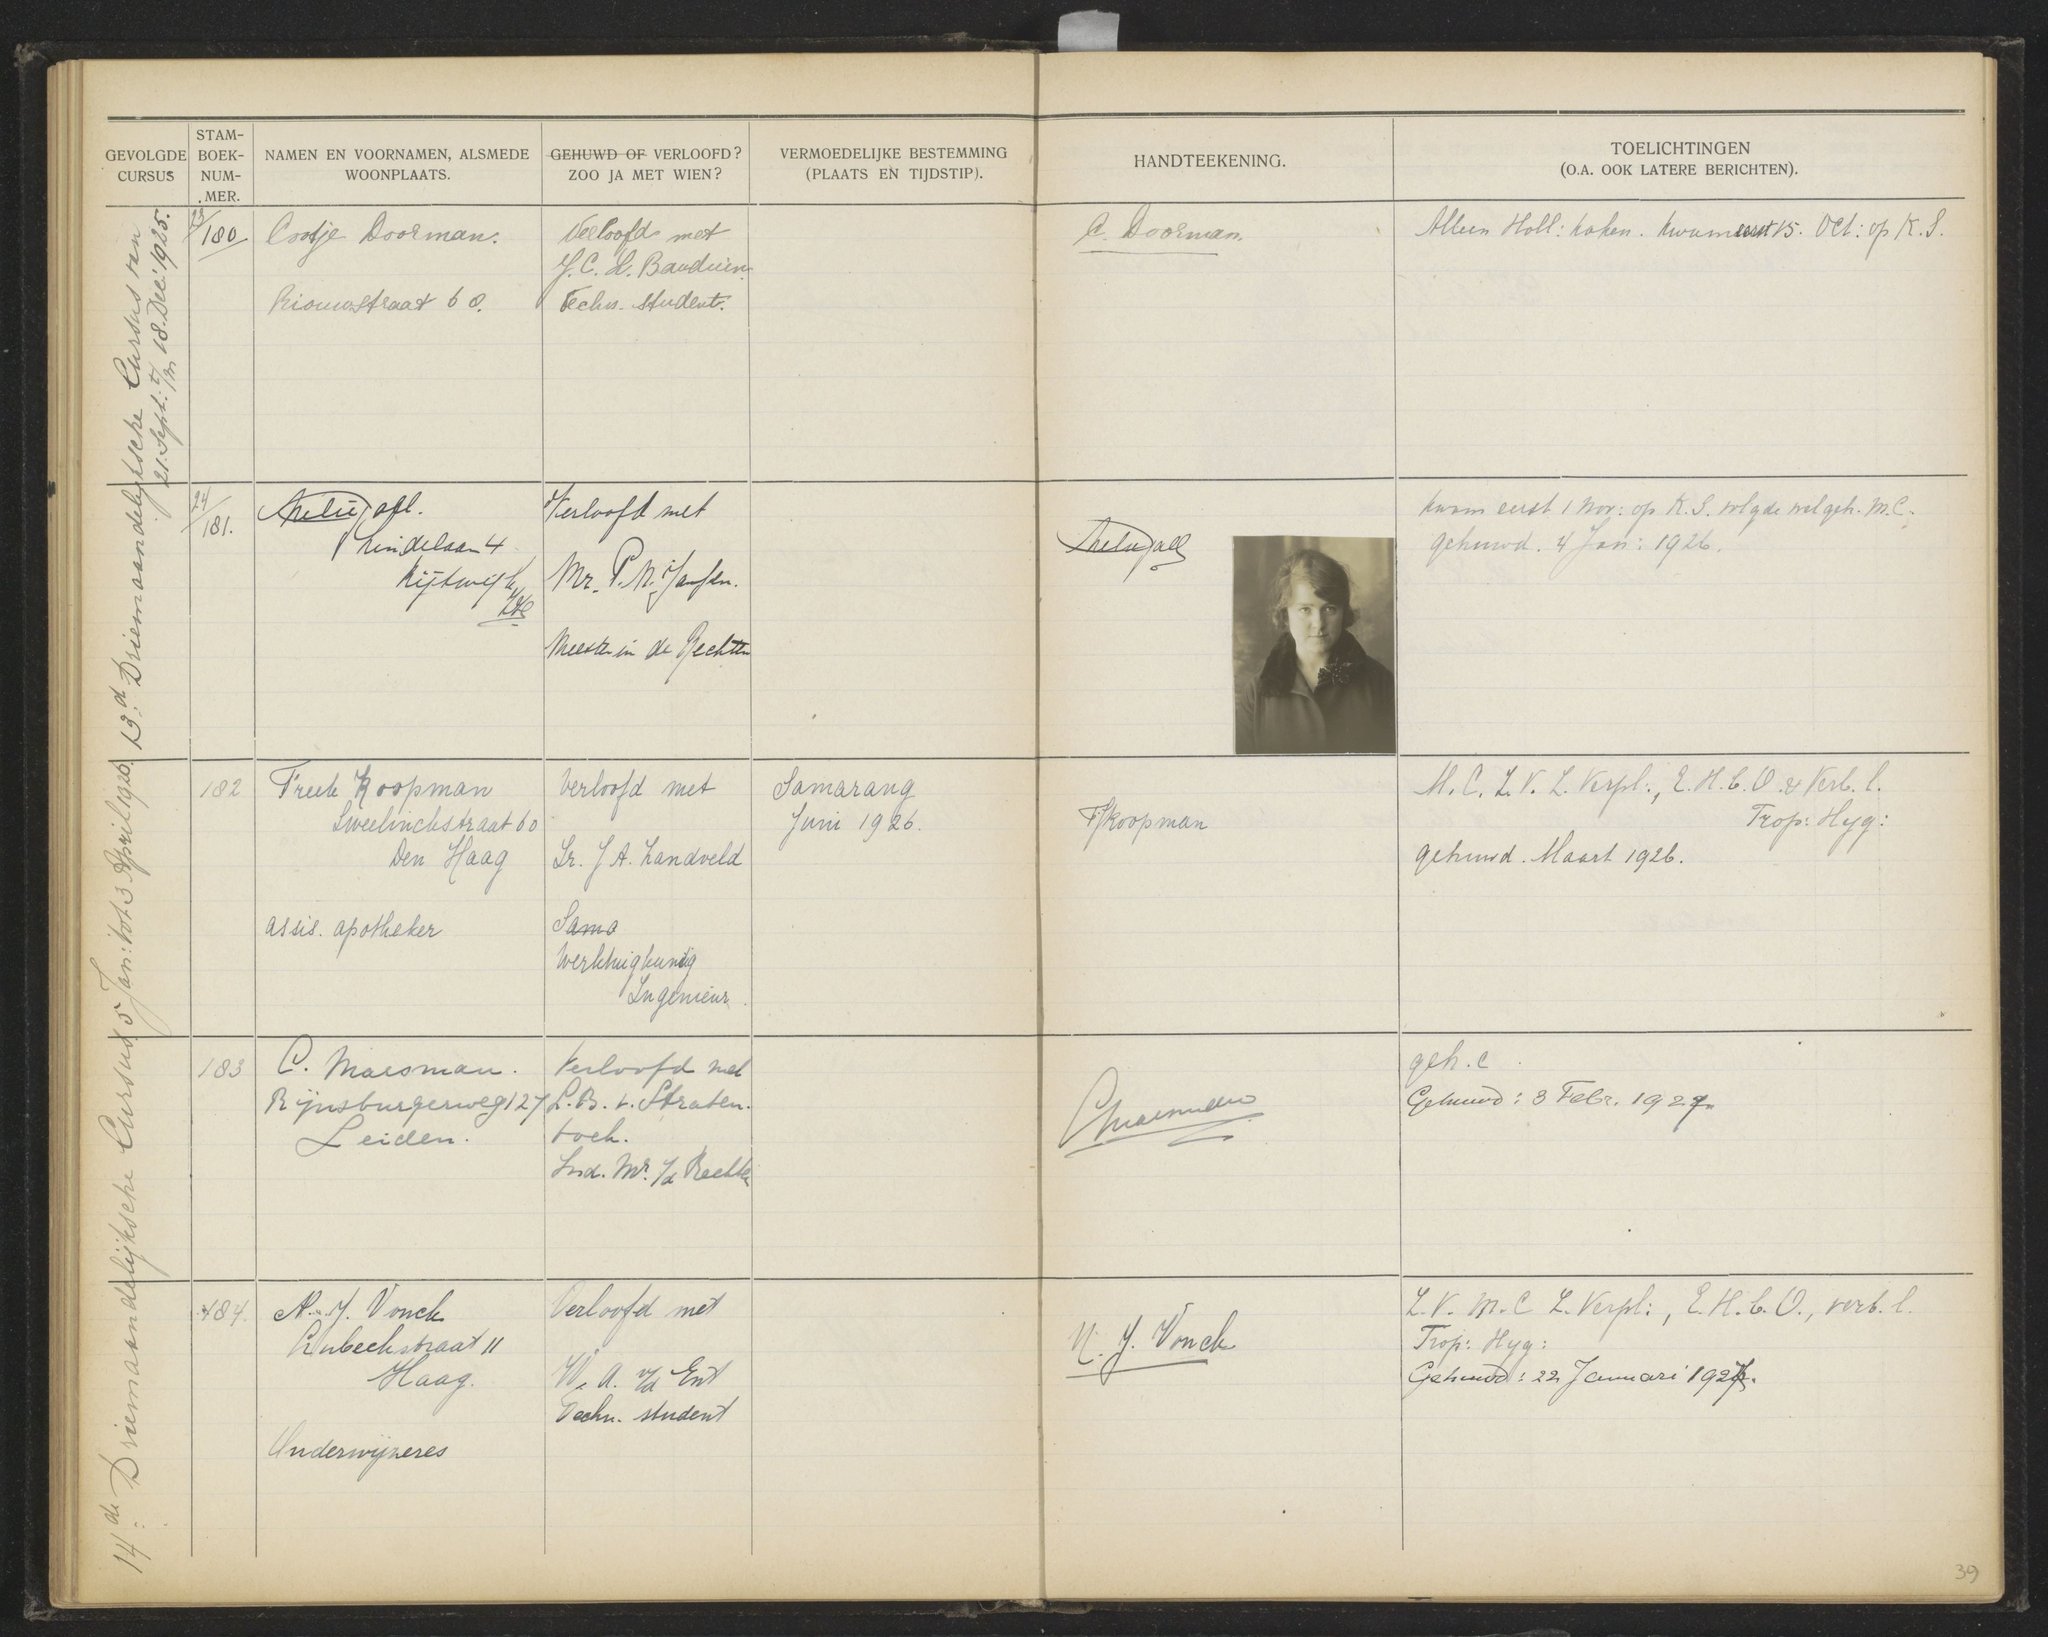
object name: album leaf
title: Blad 39 uit Stamboek van de leerlingen der Koloniale School voor Meisjes en Vrouwen te 's-Gravenhage deel I (1921-1929)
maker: Anonymous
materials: paper, photographic support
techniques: photography, printing, writing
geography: the hague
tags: further education (+ pupil), further education, the hague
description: Twee pagina's met gegevens van de deelnemers aan de 13e en 14e driemaandelijkse cursus resp. van 21 september tot en met 18 december 1925 en 5 januari tot en met 3 april 1926, stamboeknummers 180 tot en met 184. Onderdeel van Stamboek van de leerlingen der Koloniale School voor Meisjes en Vrouwen te 's-Gravenhage deel I (1921-1929).